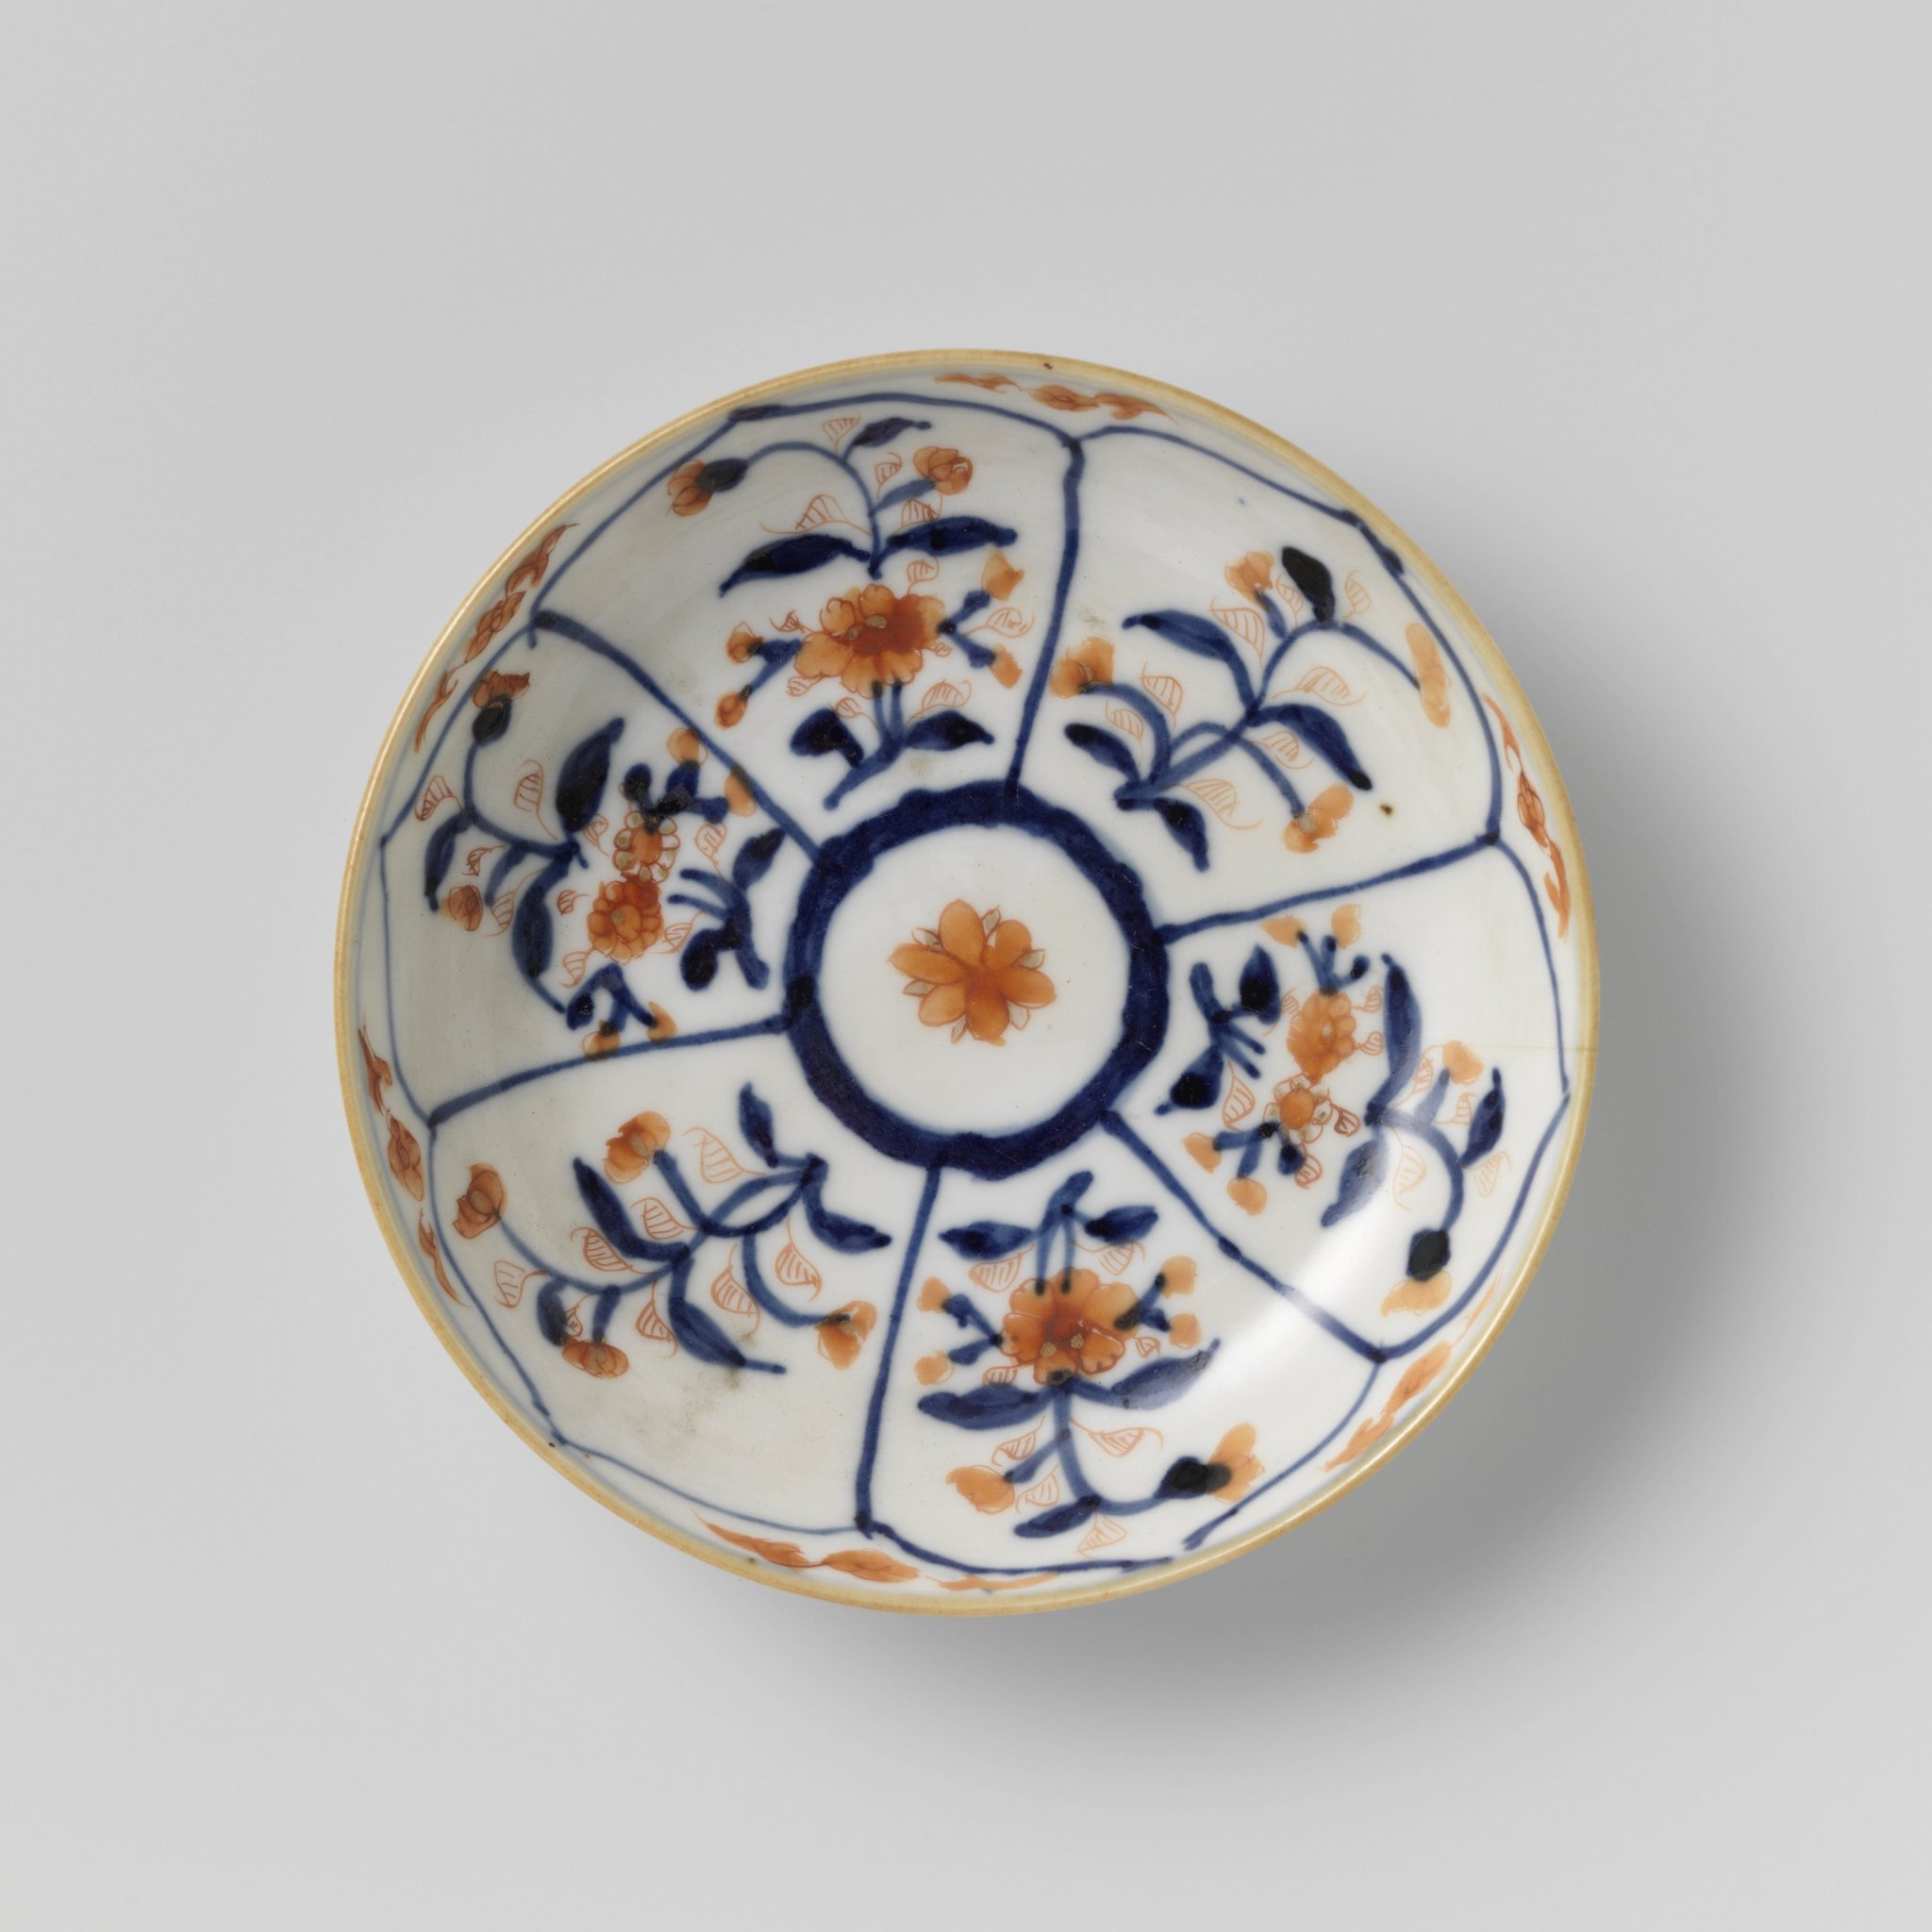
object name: kop en schotel, kop en schotel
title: Saucer with petal-shaped panel around a central medallion, filled with flower sprays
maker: Anonymous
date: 1750-1774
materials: cobalt, glaze, gold, paint, porcelain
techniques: firing, gilding, turning, vitrification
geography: china